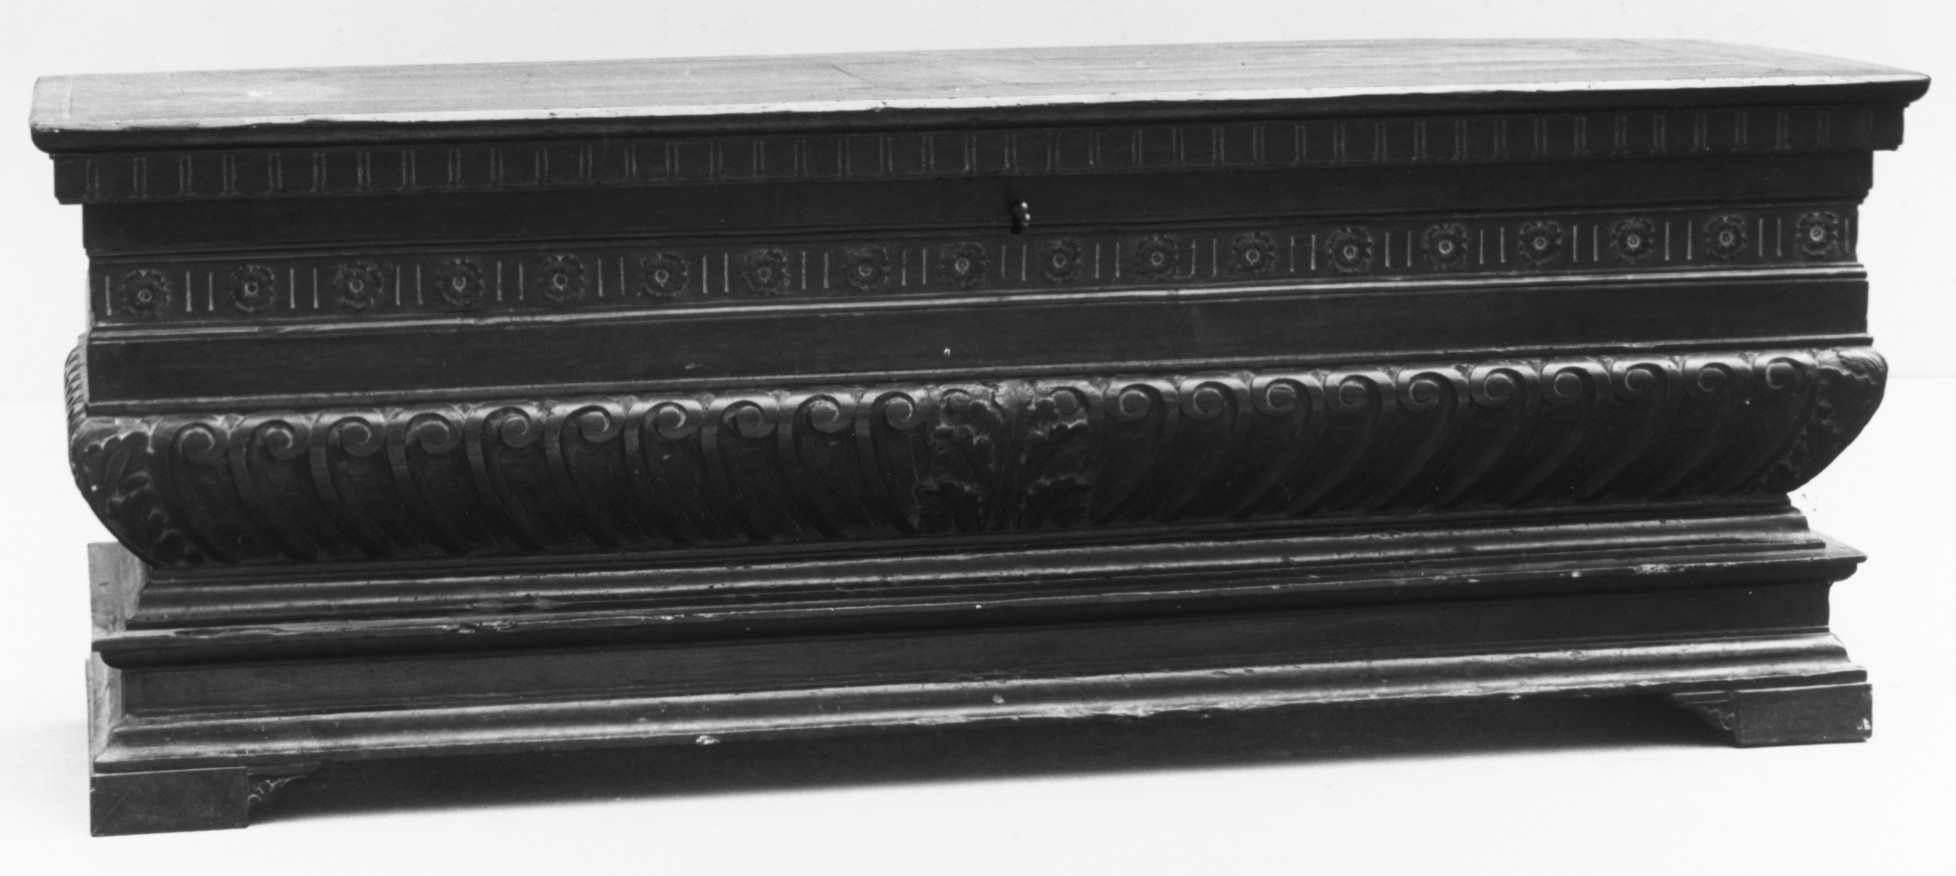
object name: cassone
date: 1534-1566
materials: wood